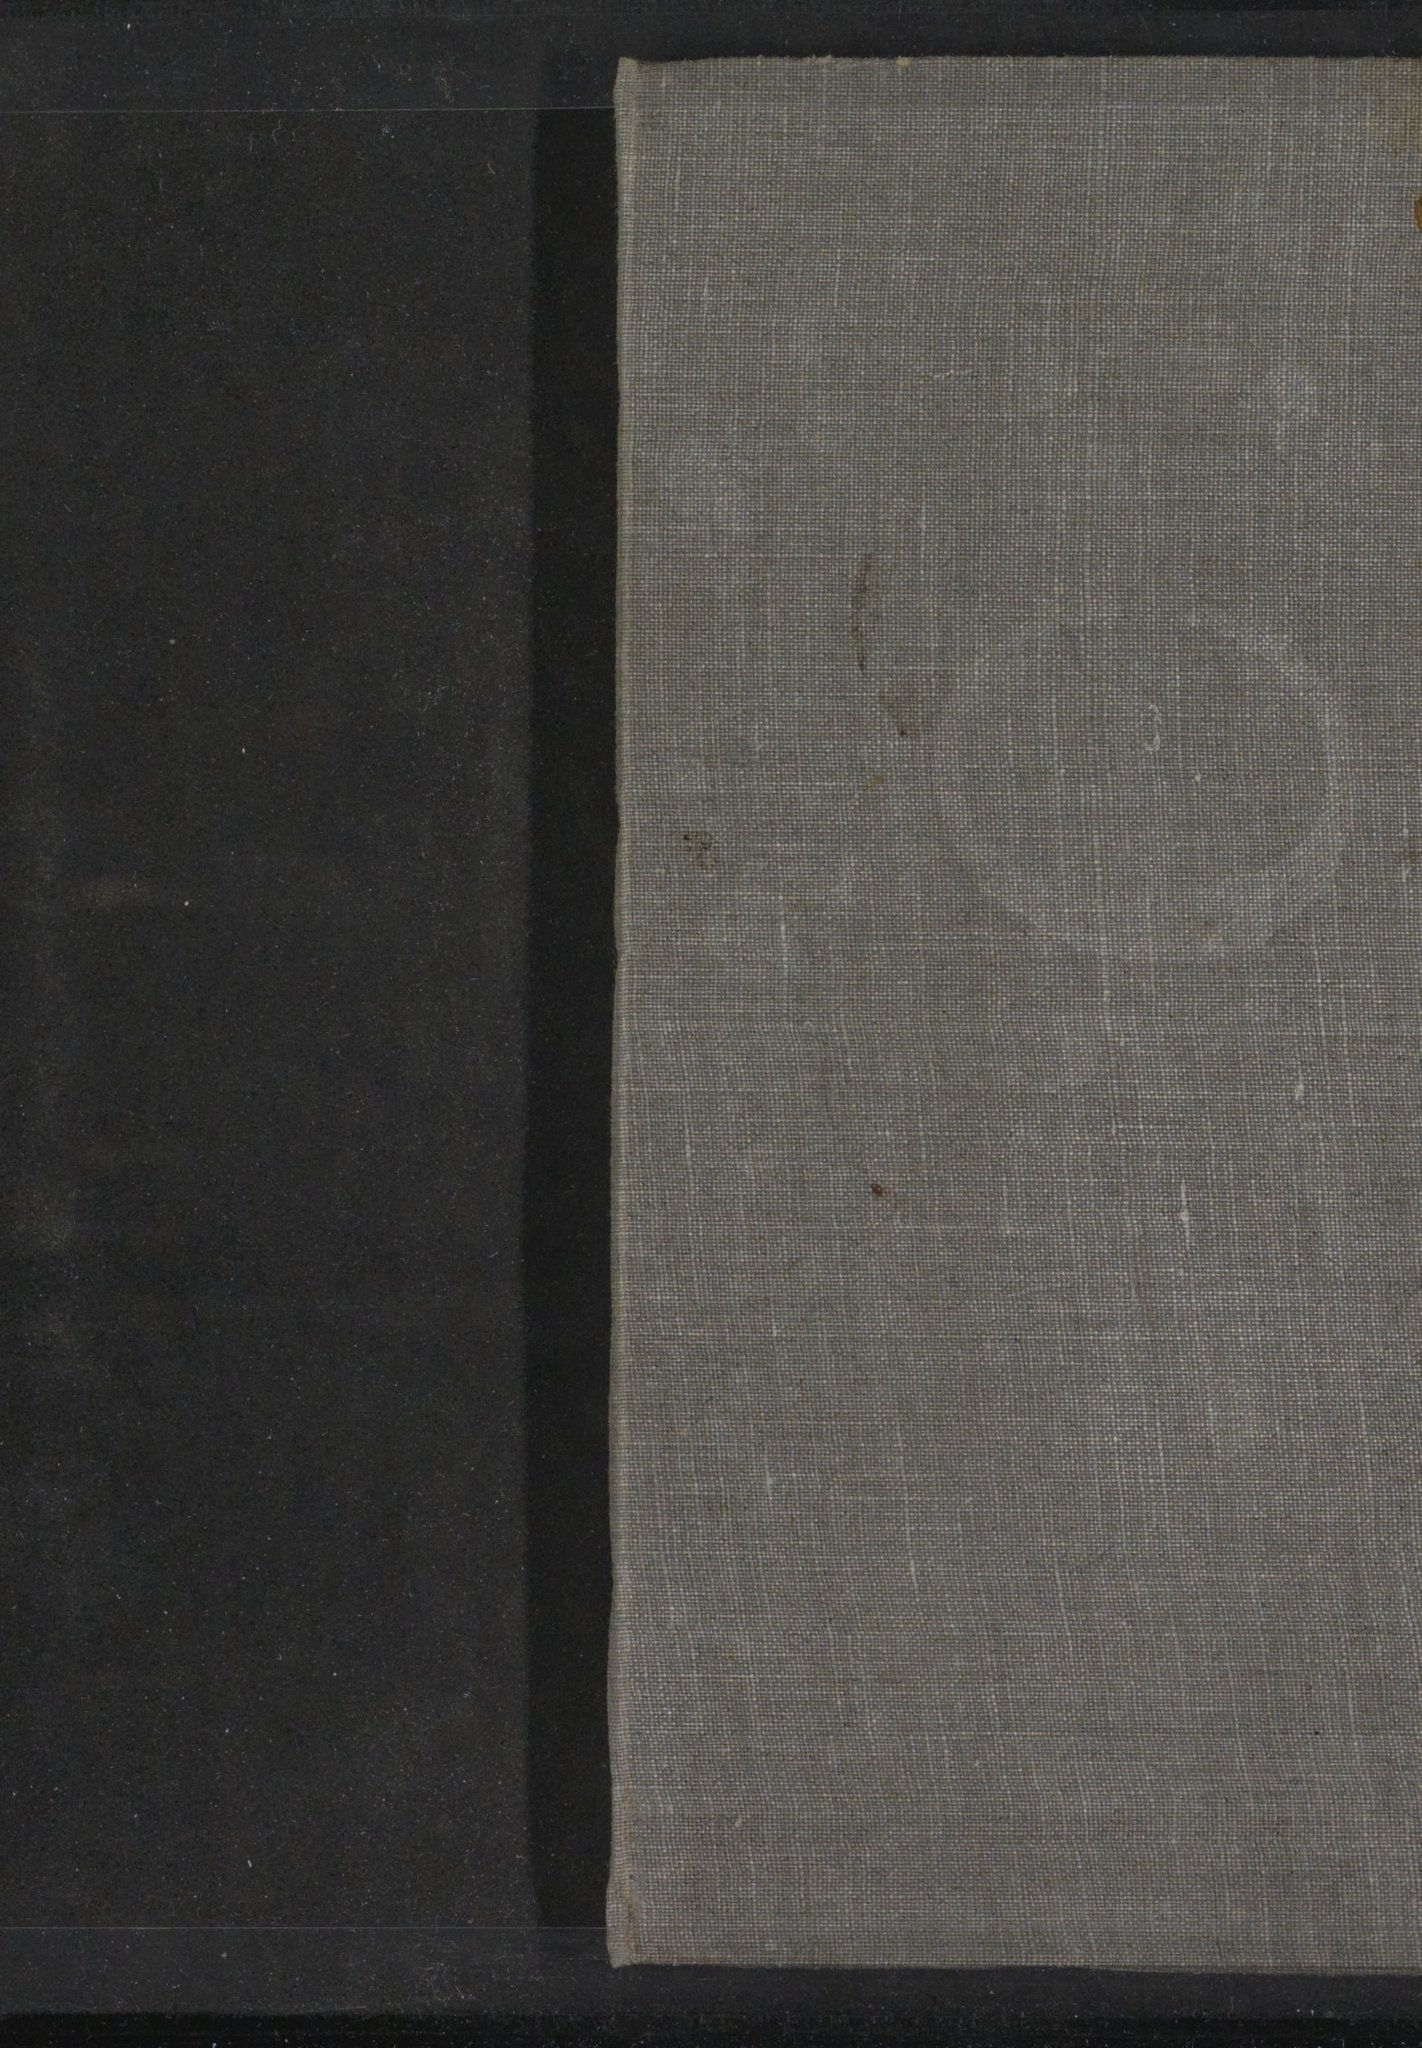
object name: sketchbook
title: Schetsboek met 75 bladen vervaardigd te Nederlands-Indië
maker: willem witsen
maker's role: draughtsman, painter, print maker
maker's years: 1860-1923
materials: cardboard, linen, paper, pencil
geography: dutch east indies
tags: landscapes in tropical and sub-tropical regions, housing, lizards: lizard, trees: palm-tree, dutch east indies, the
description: Pagina 11 t/m pagina 28, pagina 31 t/m pagina 53, pagina 55 t/m 64 en pagina 67 en verder bevatten geen voorstelling.